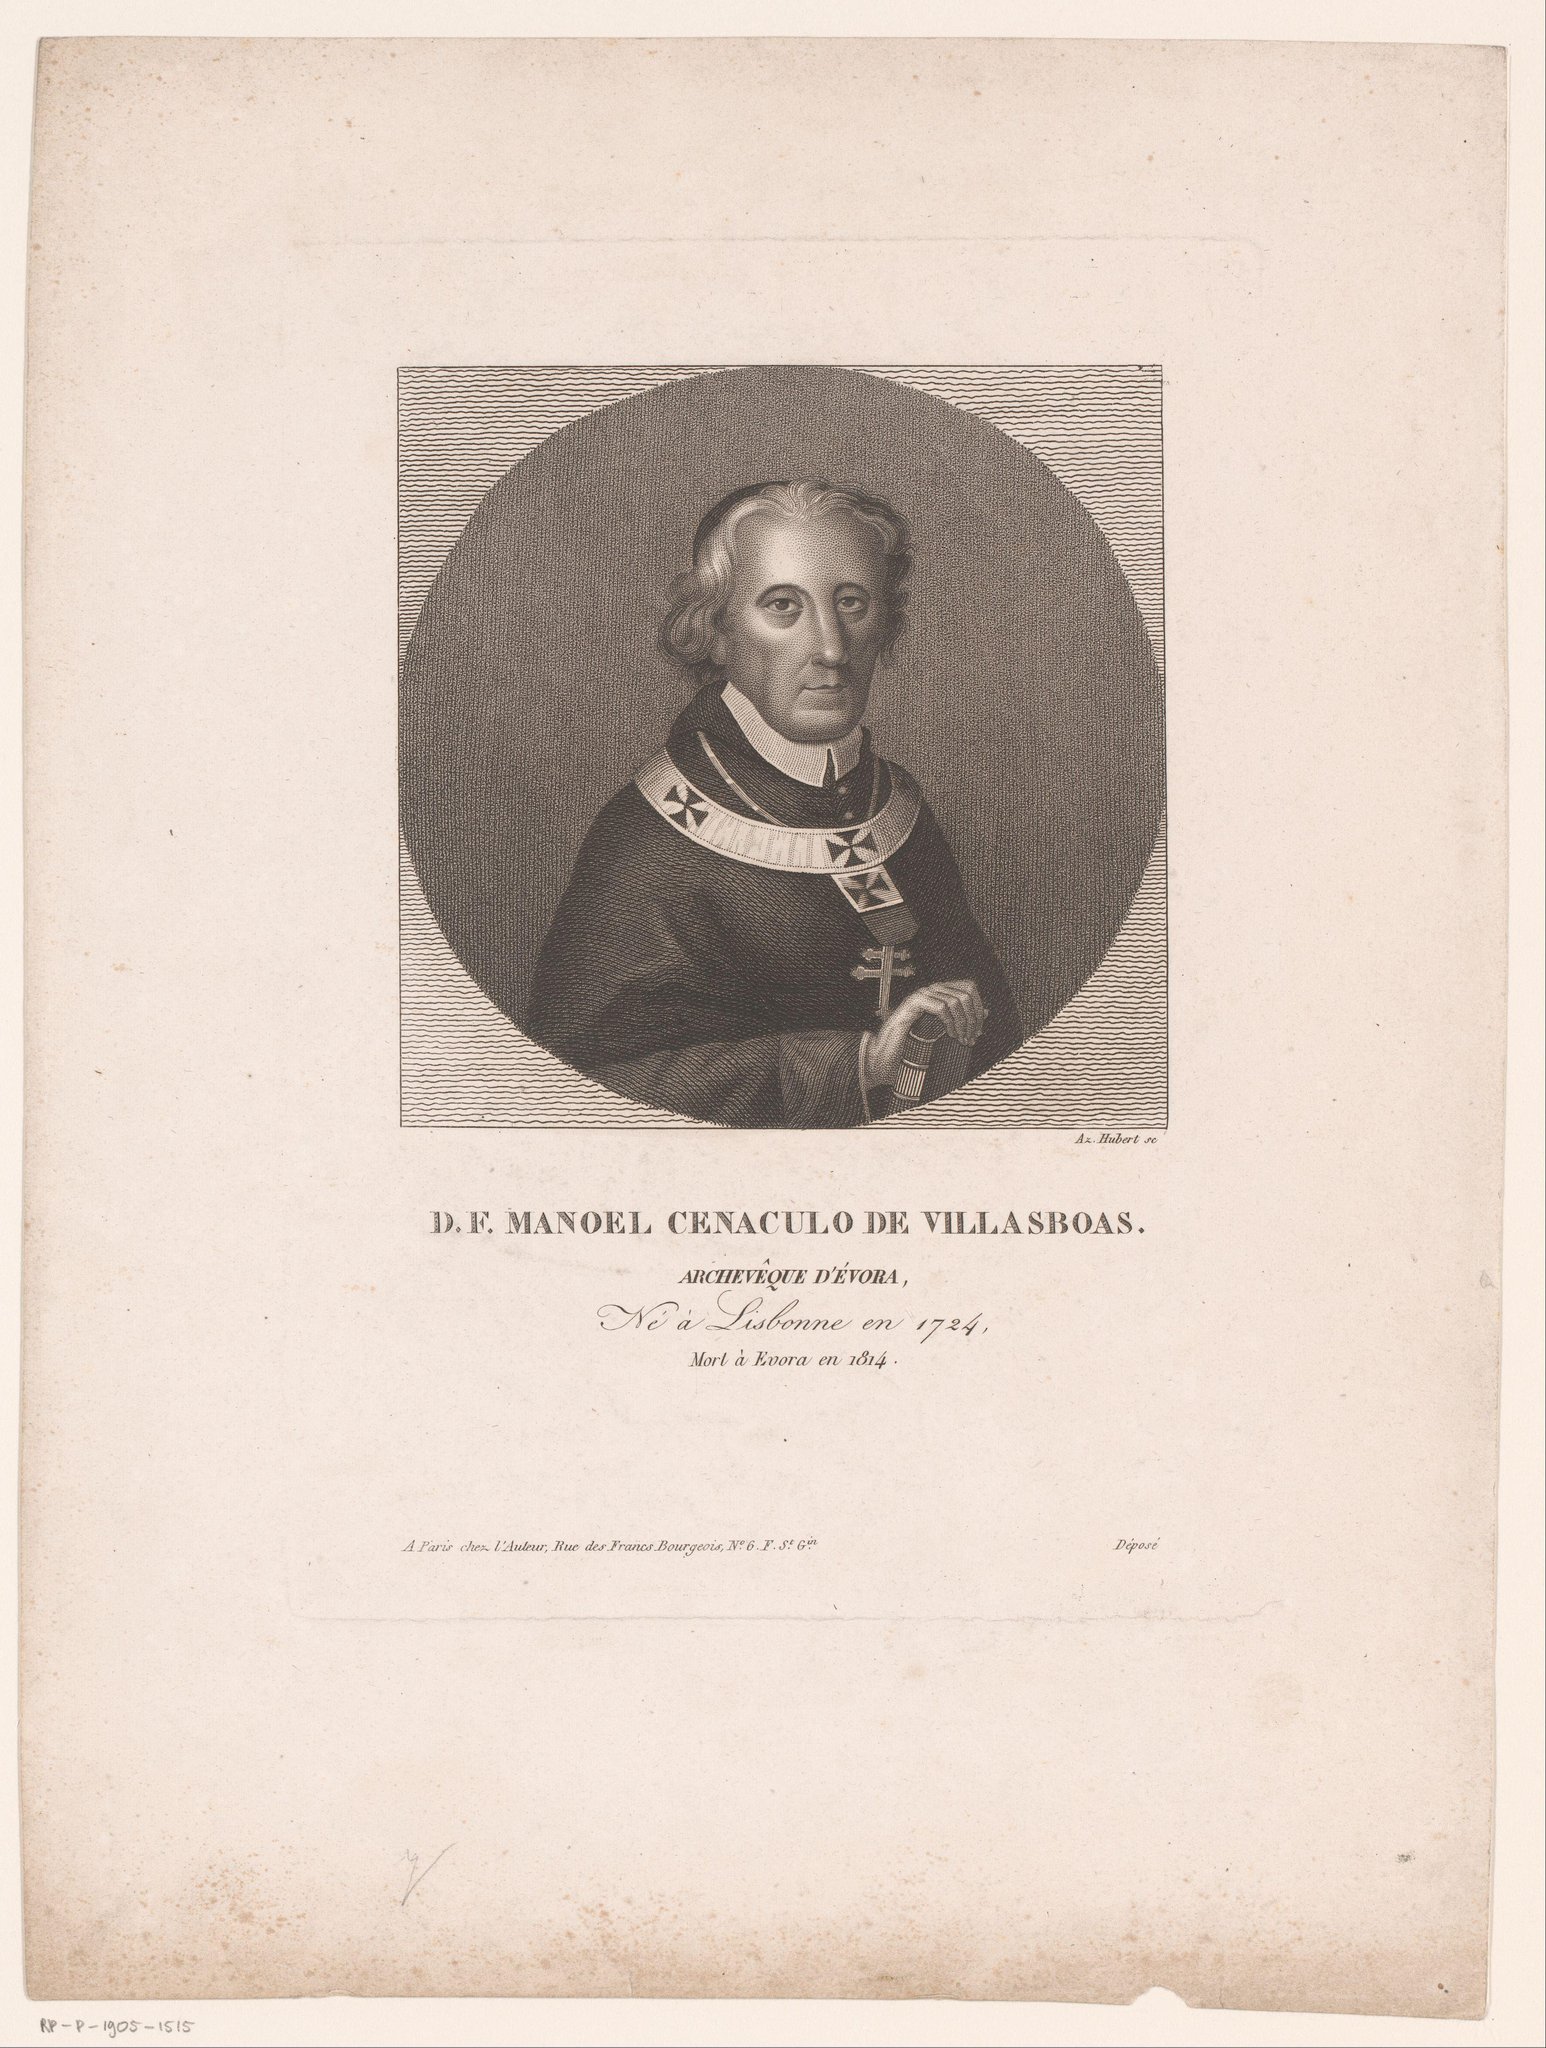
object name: print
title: D.F. Manoel Cenaculo de Villasboas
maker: hél. hubert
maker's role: print maker, publisher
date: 1811-1841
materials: paper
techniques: etching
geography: paris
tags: archbishop, bishop, etc. (roman catholic), historical persons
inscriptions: : ‘Déposé.’, collector's mark: Lugt 2228